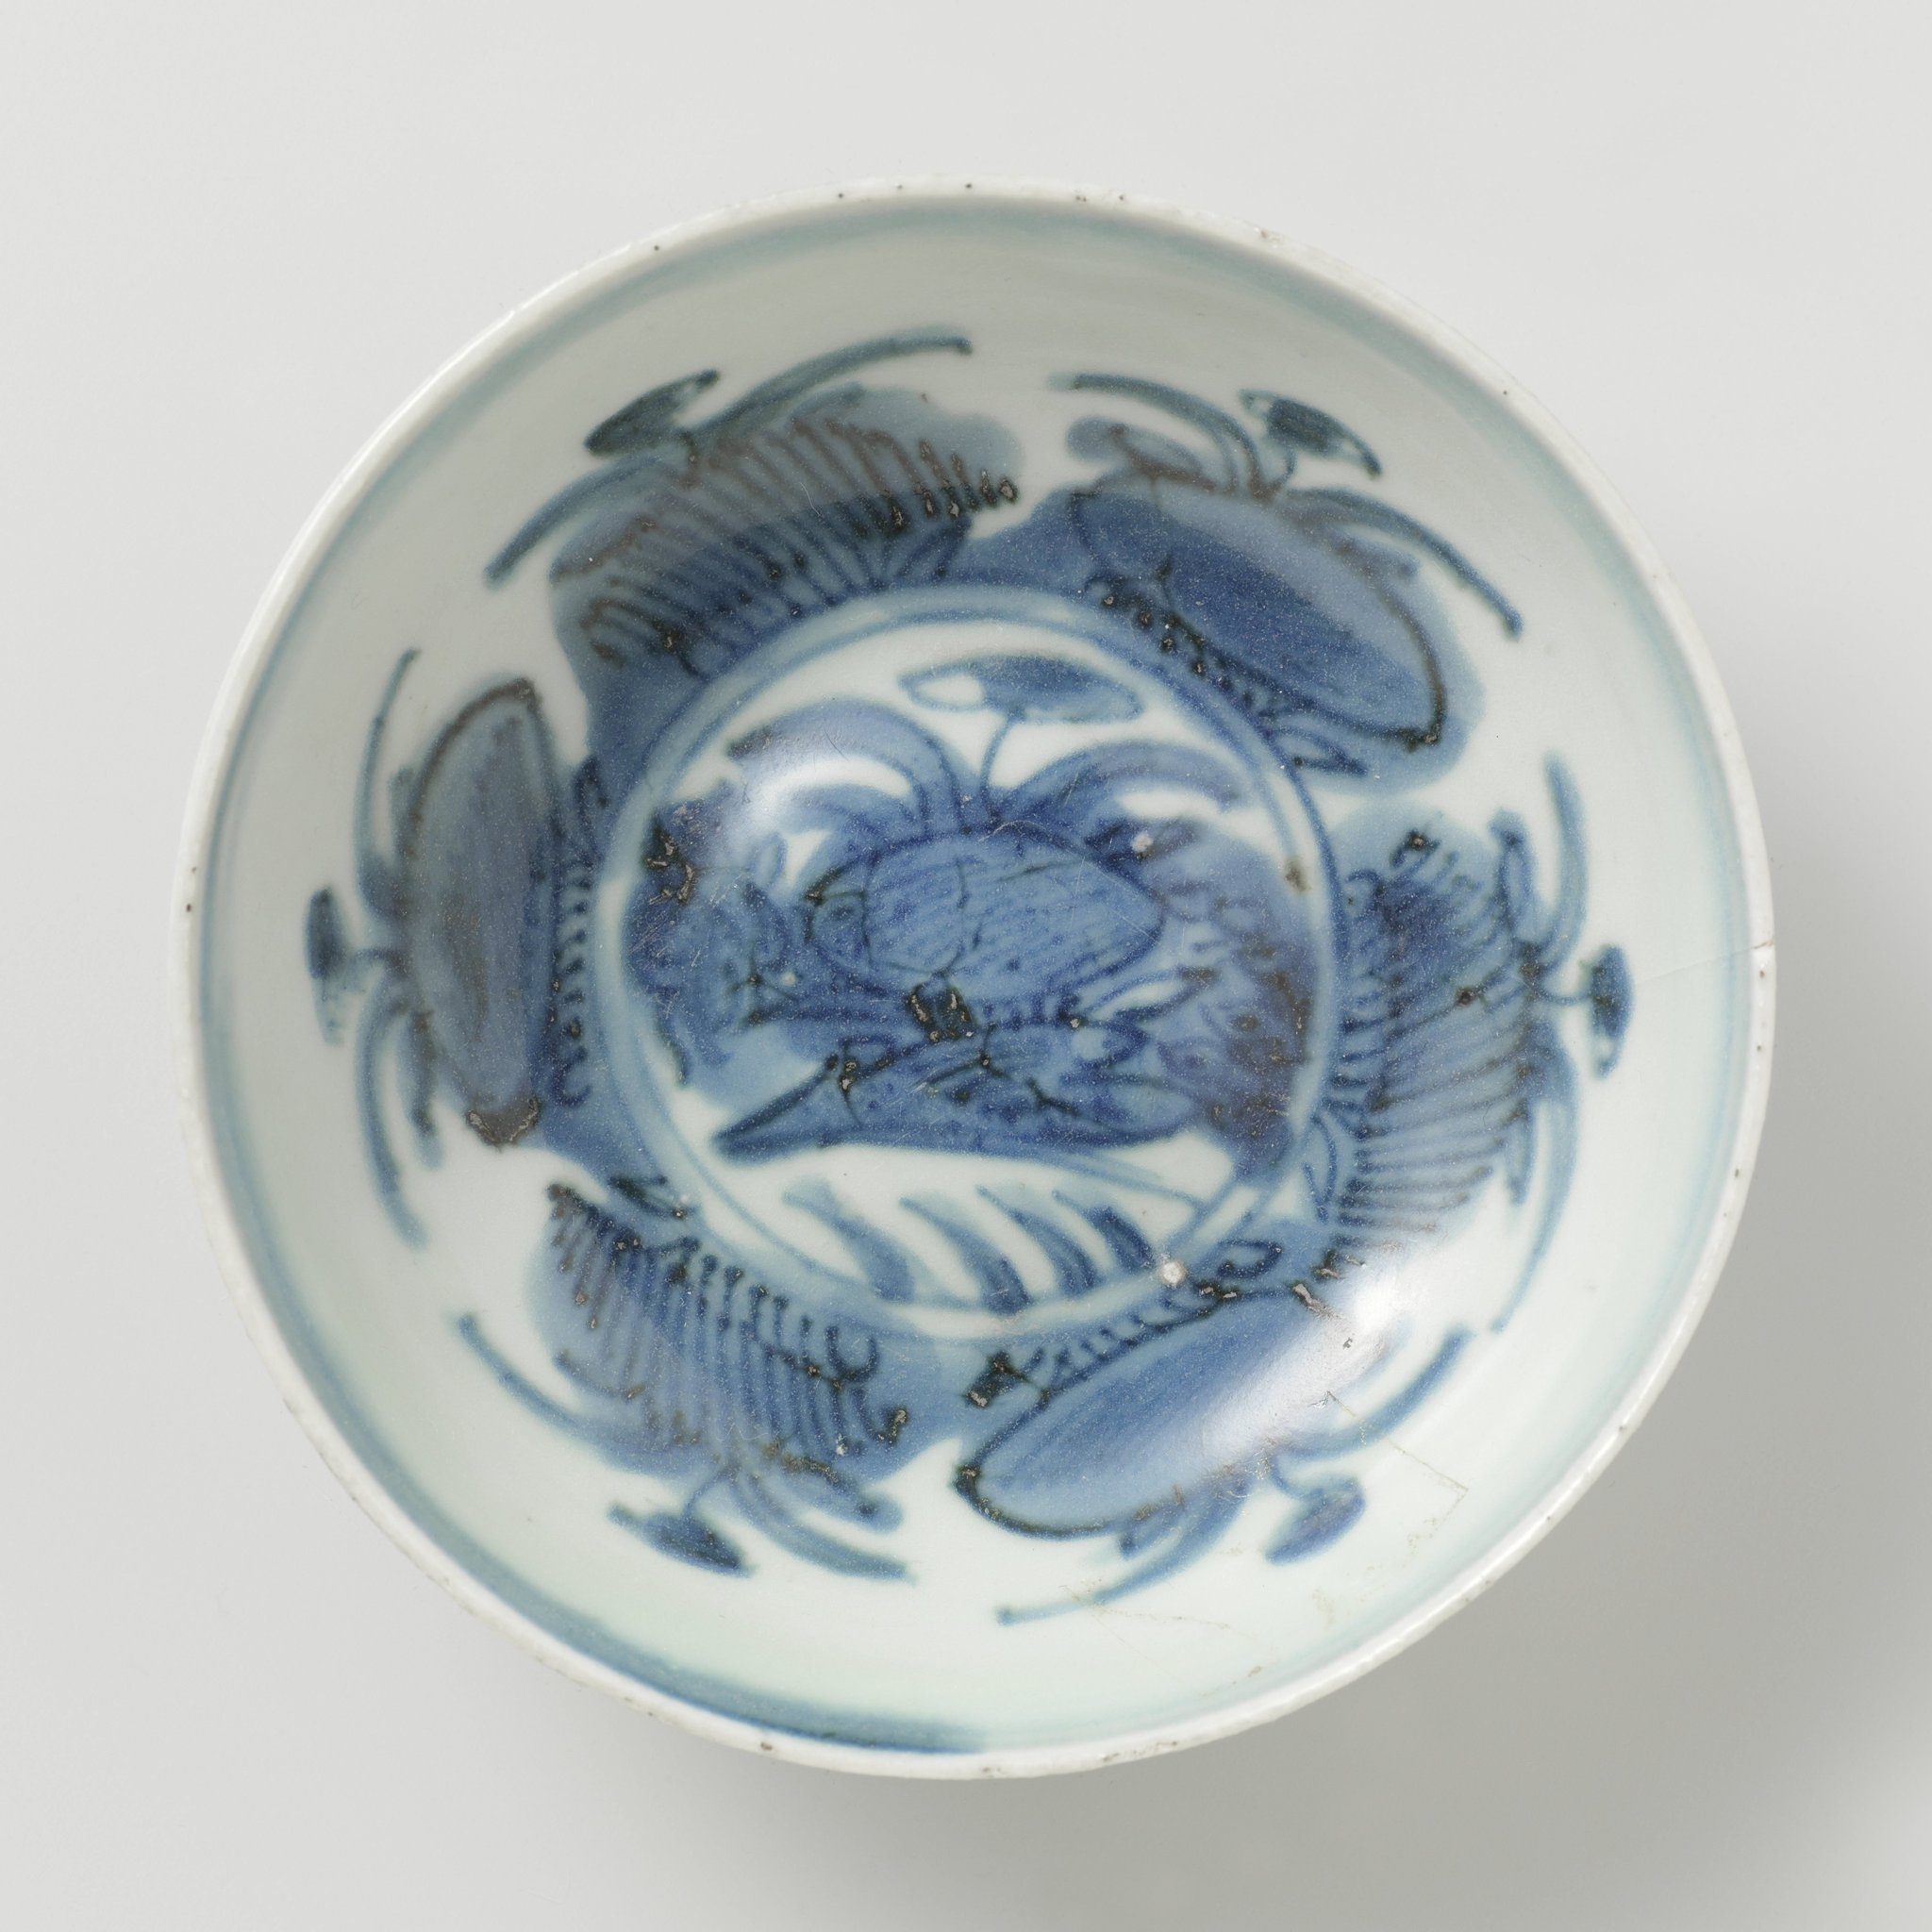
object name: platter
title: Schotel uit V.O.C.-schip de 'Witte Leeuw'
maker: Anonymous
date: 1613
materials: porcelain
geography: jingdezhen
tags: lotus ~ ornament - aa - stylized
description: A saucer. The decoration on the inside consists of a flowering lotus plant with a duck underneath in the centre. On the cavetto 6 similar lotus plants are drawn.